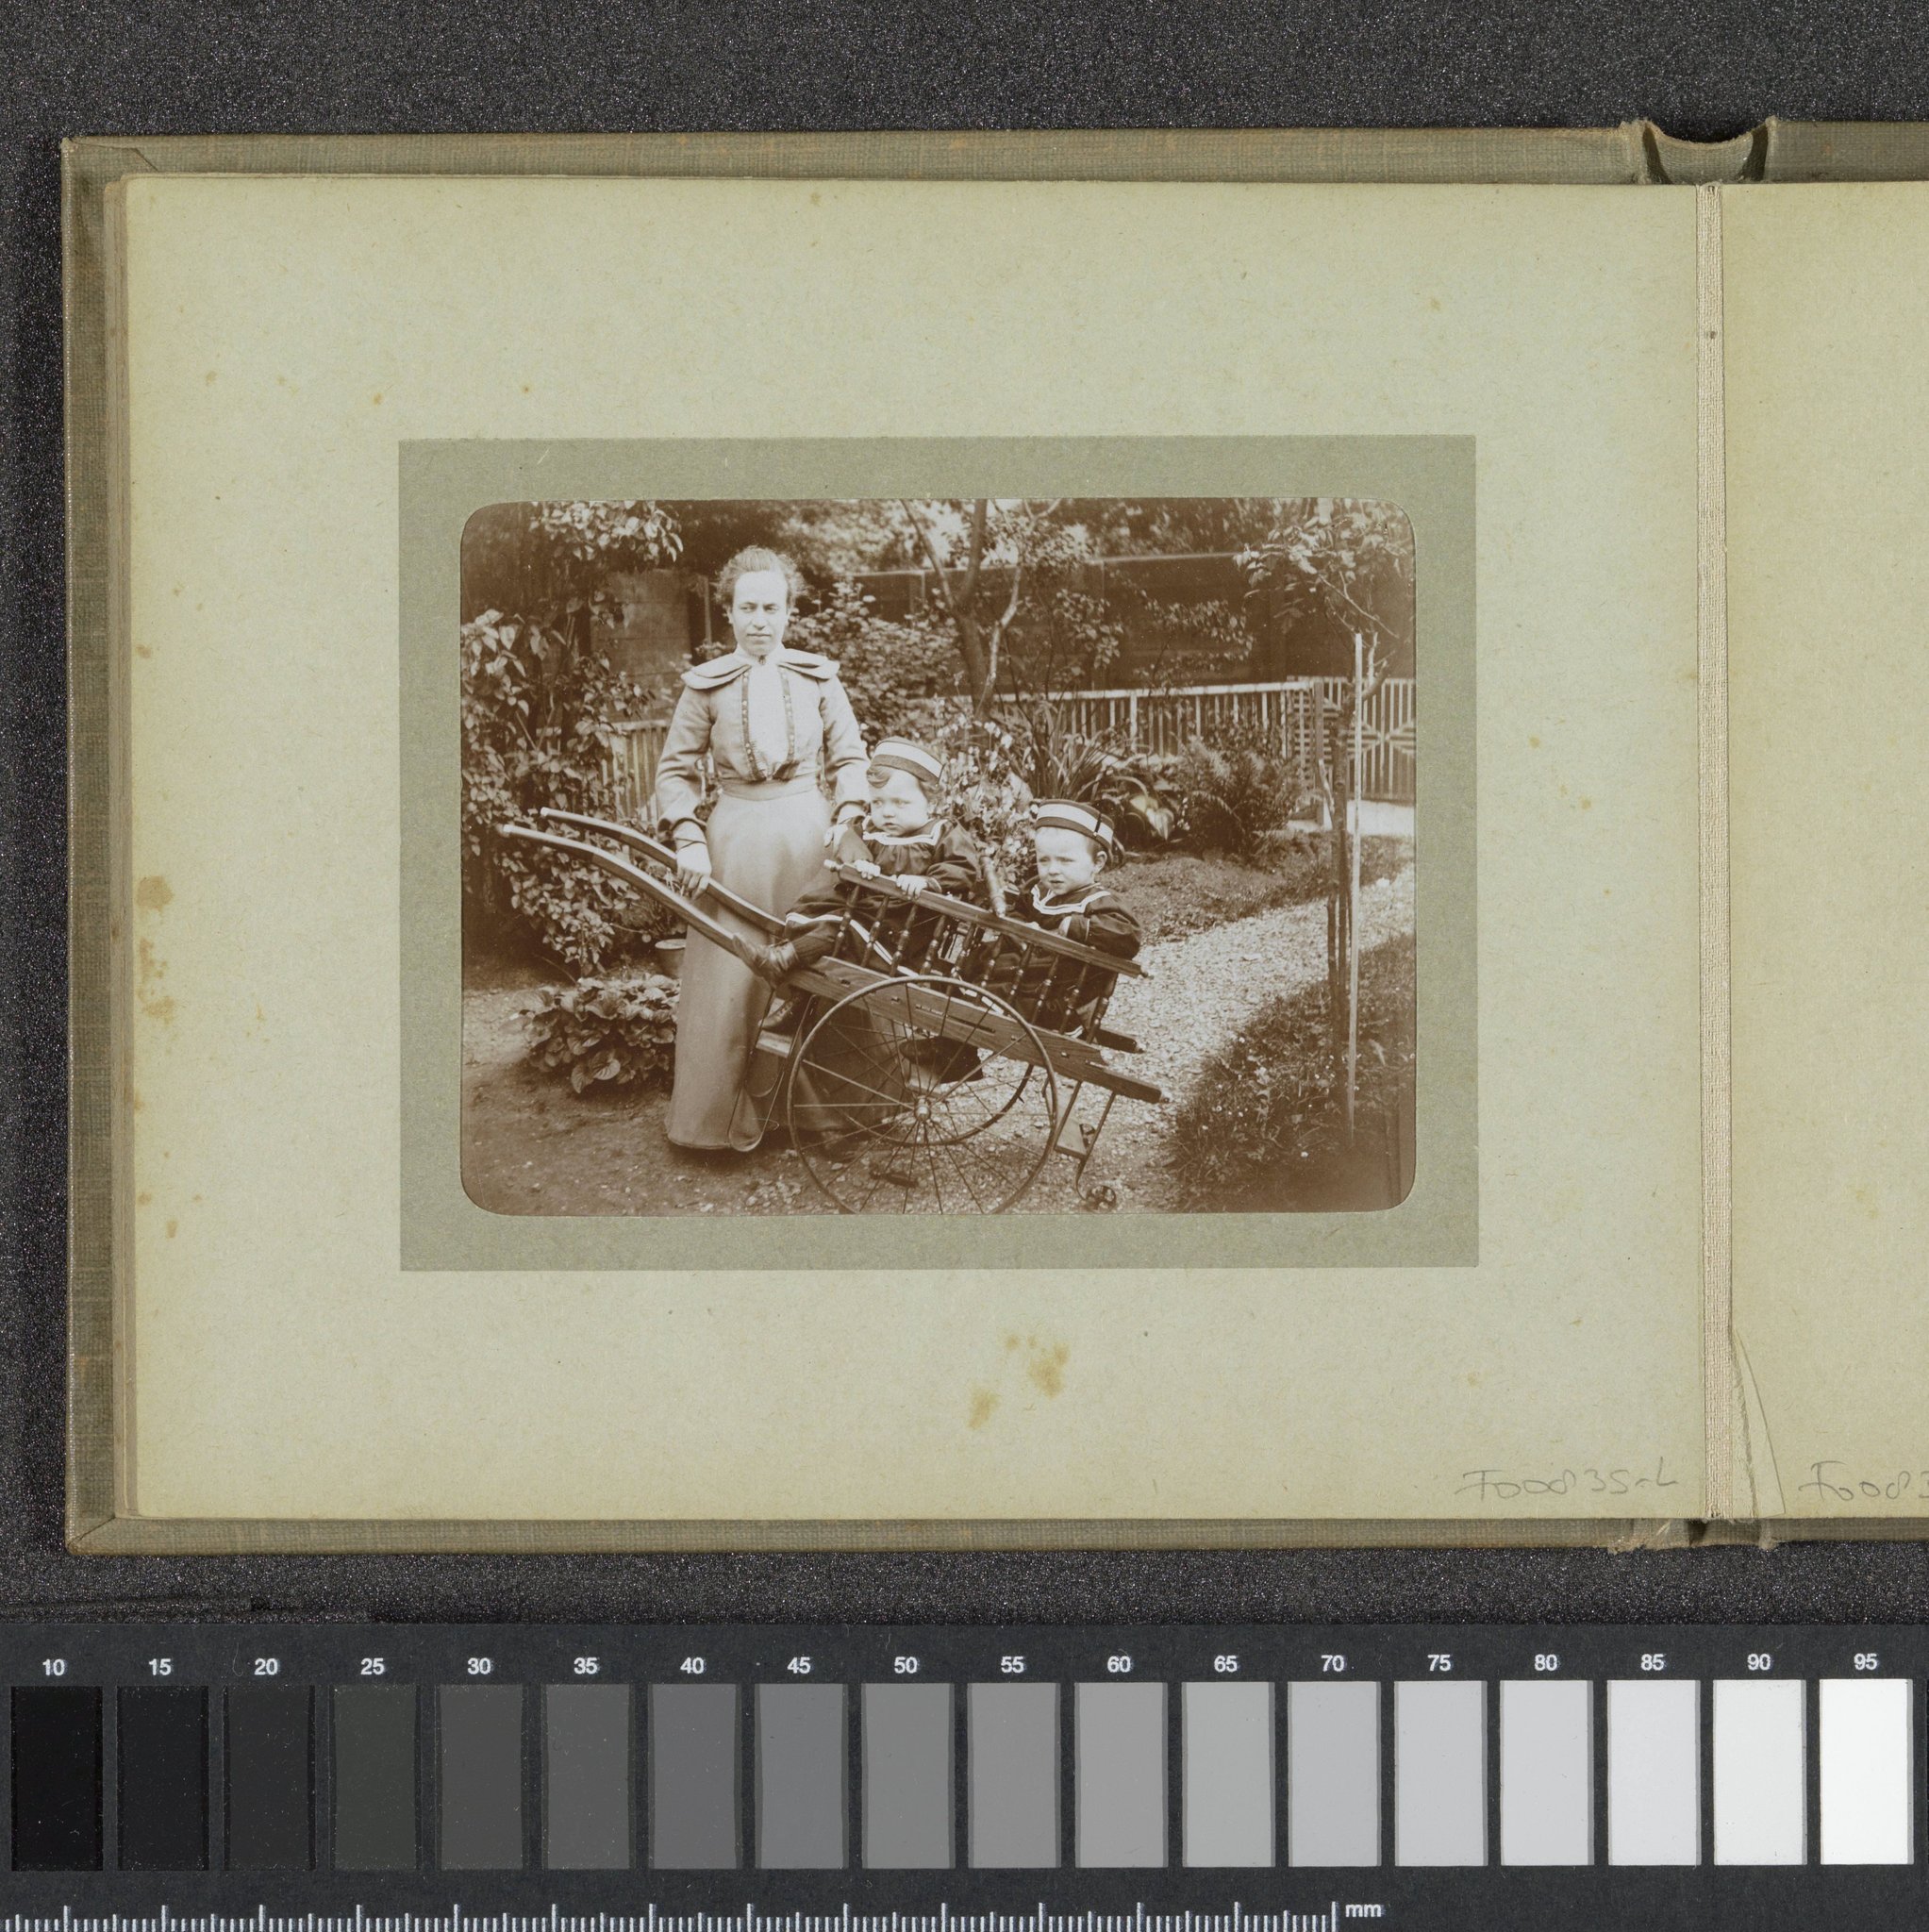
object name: photograph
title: Vrouw met twee peuters met dezelfde kleding en petten in een bolderkar, waarschijnlijk de tweeling Ad en Johanna van der Kop en een familielid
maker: willem carel van der kop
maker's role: amateurfotograaf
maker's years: 1869-1924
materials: cardboard, paper, photographic support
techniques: collodion silver print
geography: schoonhoven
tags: baby-carriage, pram, perambulator, twins, family life, head-gear: cap, tot, toddler ~ the ages of man, brothers or sisters (second degree family relationships)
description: Onderdeel van Fotoalbum met opnames van Ad, Johanna en Han van der Kop, hun moeder W.G. Hoogendijk en familieleden.